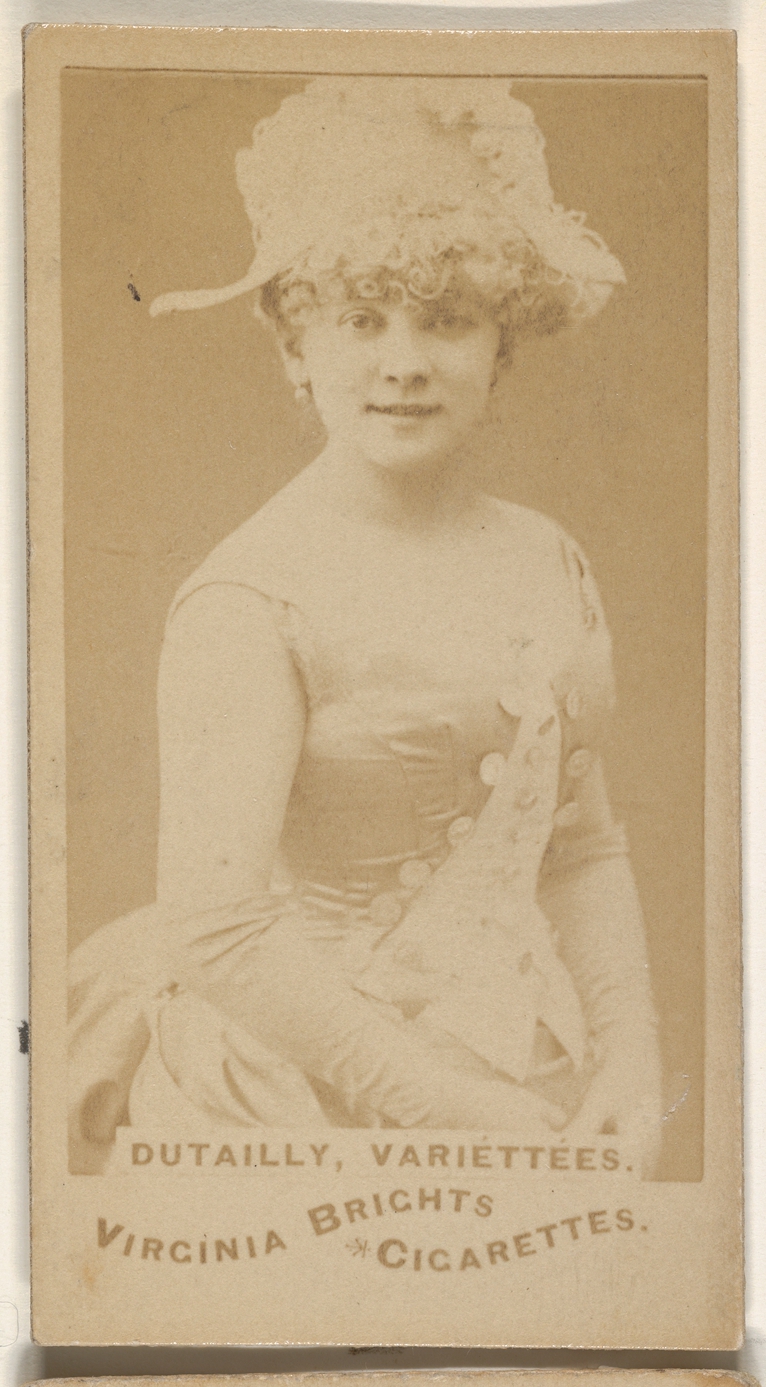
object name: photograph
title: Dutailly, Variettees, from the Actors and Actresses series (N45, Type 1) for Virginia Brights Cigarettes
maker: allen & ginter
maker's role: publisher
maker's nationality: american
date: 1888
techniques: albumen silver print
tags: portraits,women,actresses